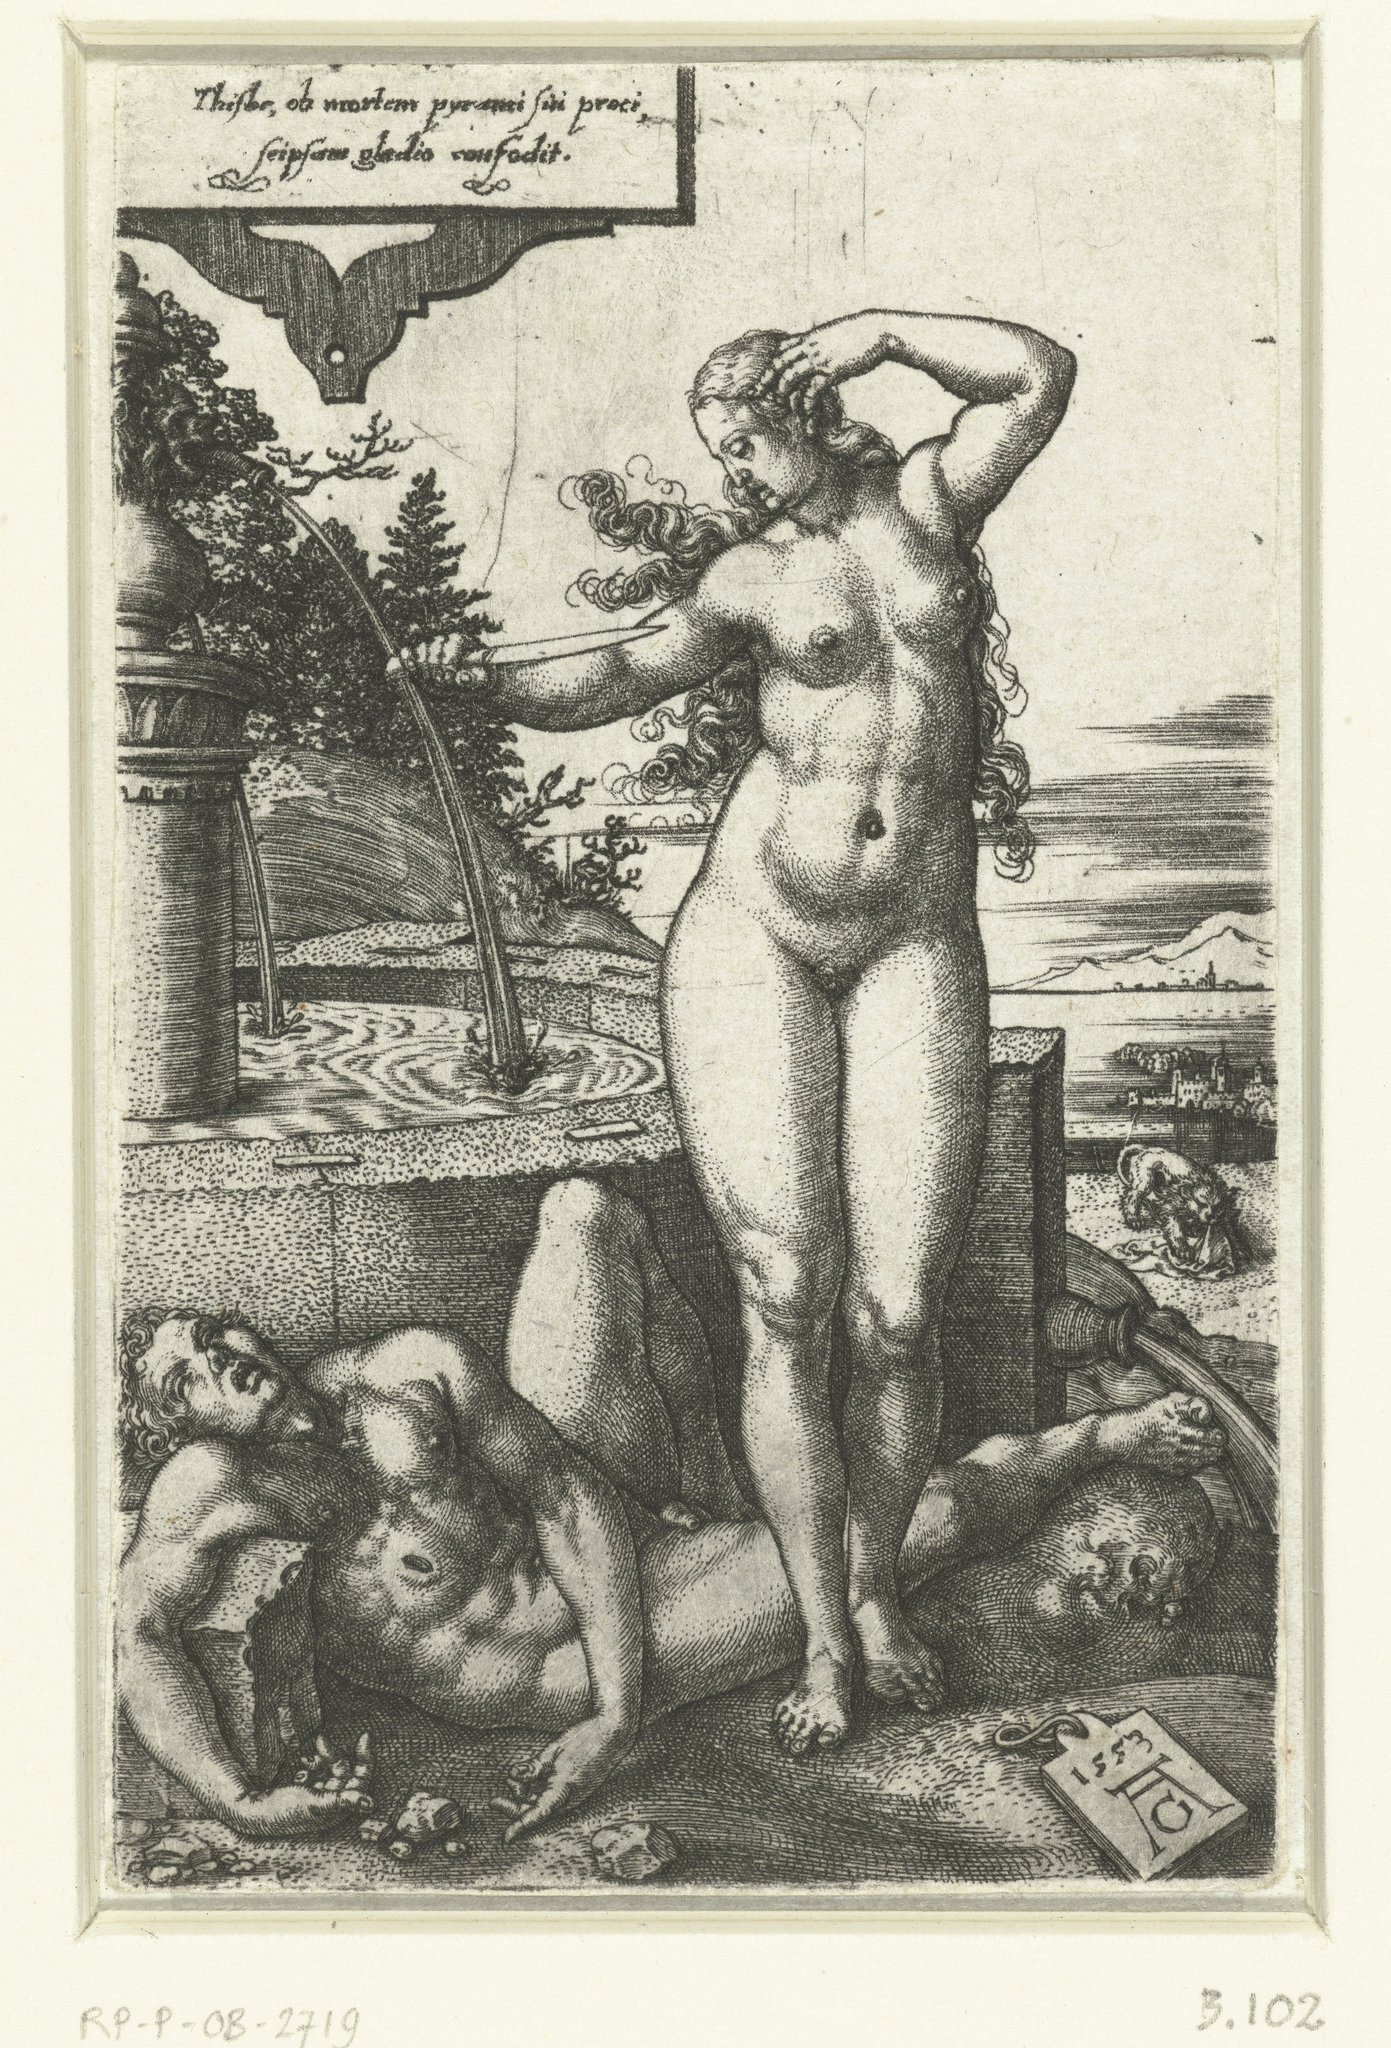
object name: print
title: Pyramus en Thisbe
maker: heinrich aldegrever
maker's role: draughtsman, print maker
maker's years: 1502-1561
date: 1553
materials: paper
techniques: engraving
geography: germany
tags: thisbe kills herself with pyramus' sword (the scene may be represented near a fountain)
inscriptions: number: ‘12’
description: De dode Pyramus, naakt liggend op de grond naast een fontein. Naast hem staat Thisbe, die op het punt staat een mes in haar borst te steken. Op de achtergrond de leeuw met haar mantel. Linksboven een cartouch met een tweeregelige tekst in het Latijn.